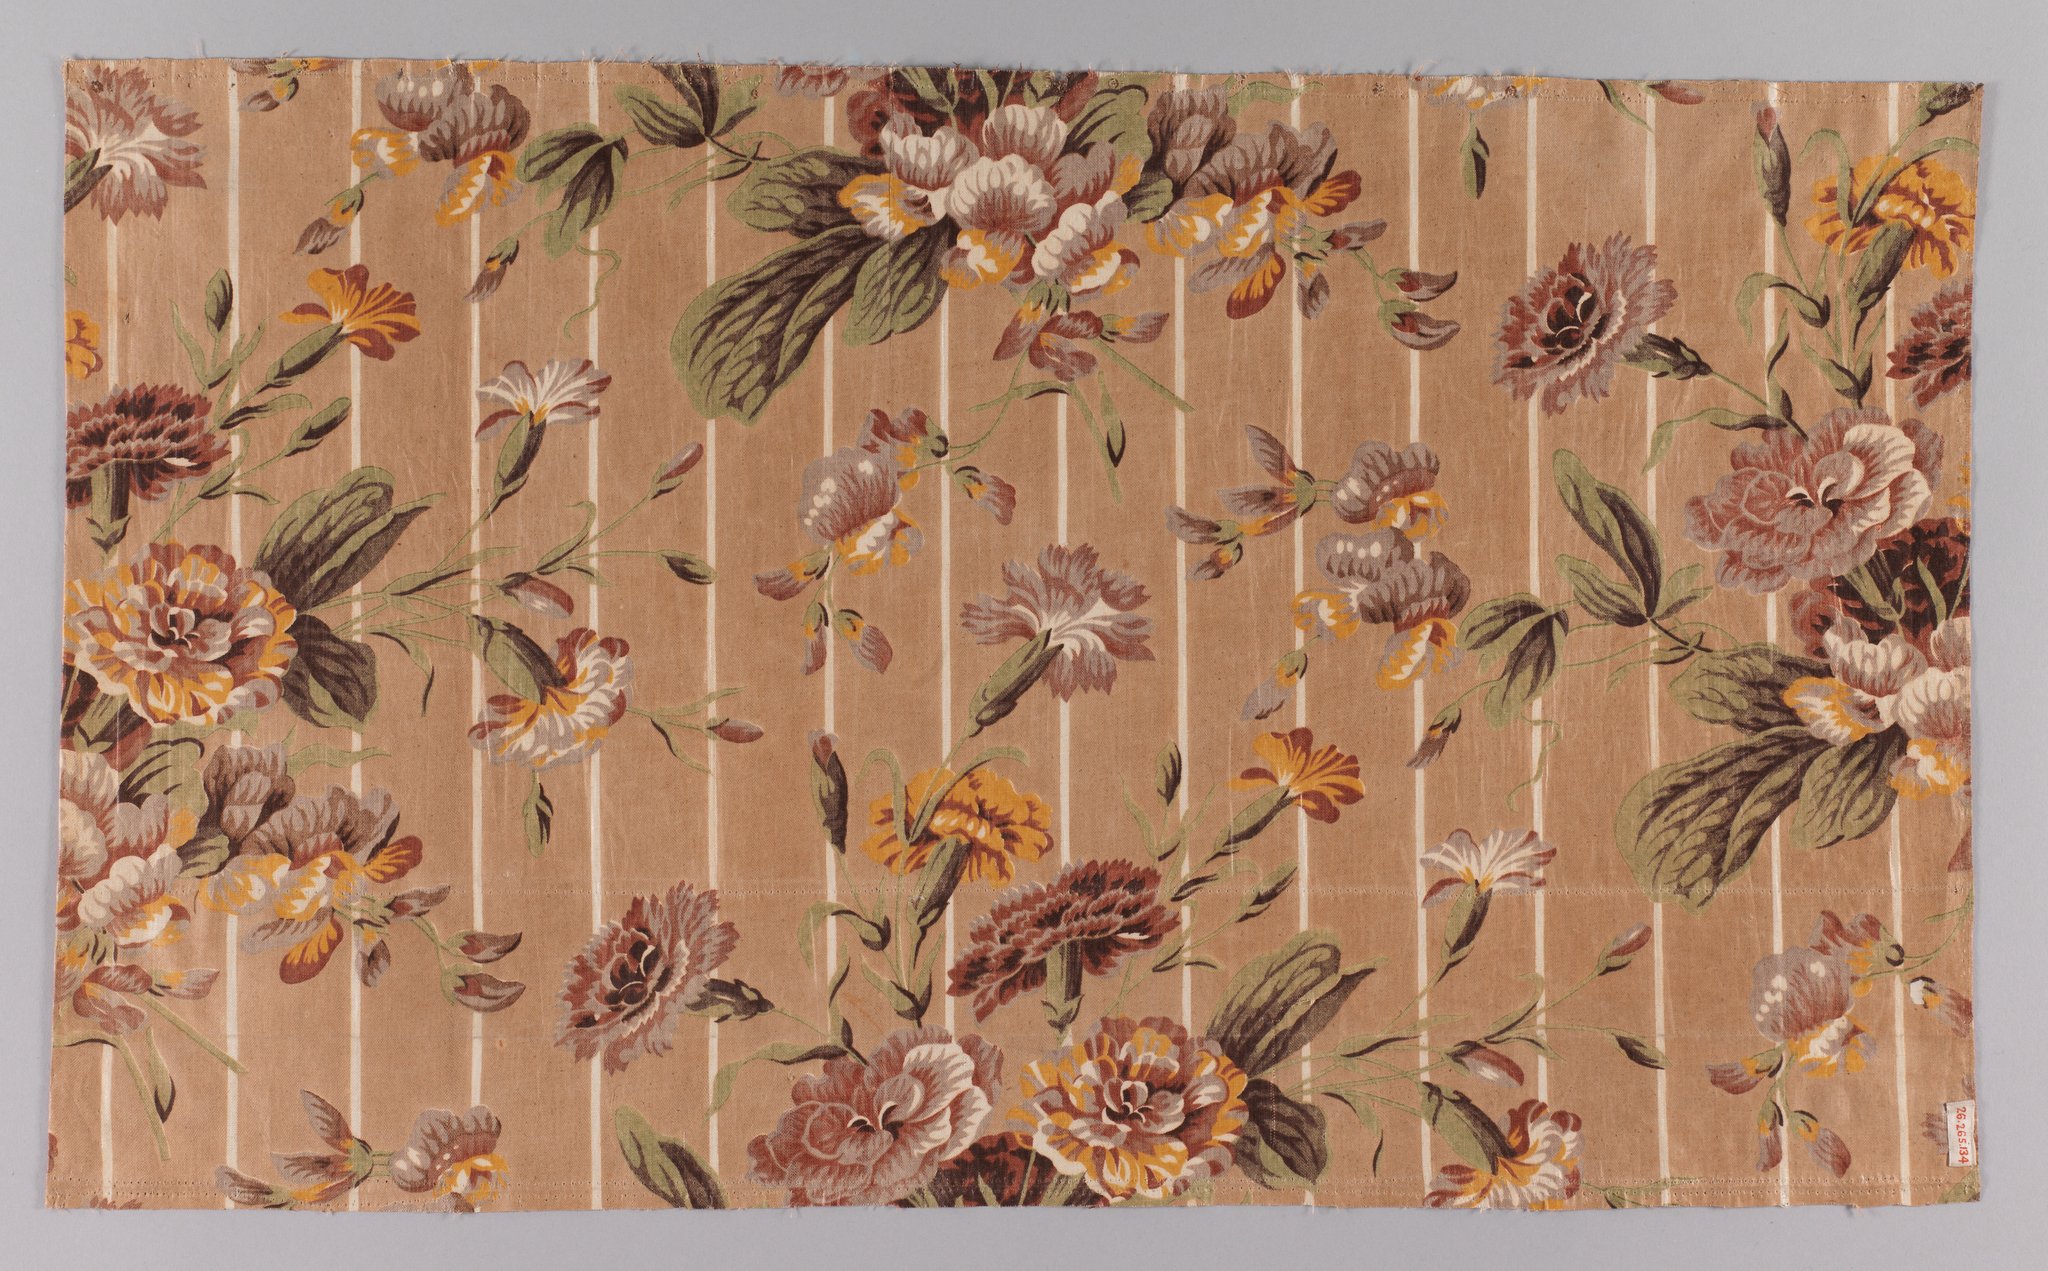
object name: piece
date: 1851-1900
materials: cotton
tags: flowers